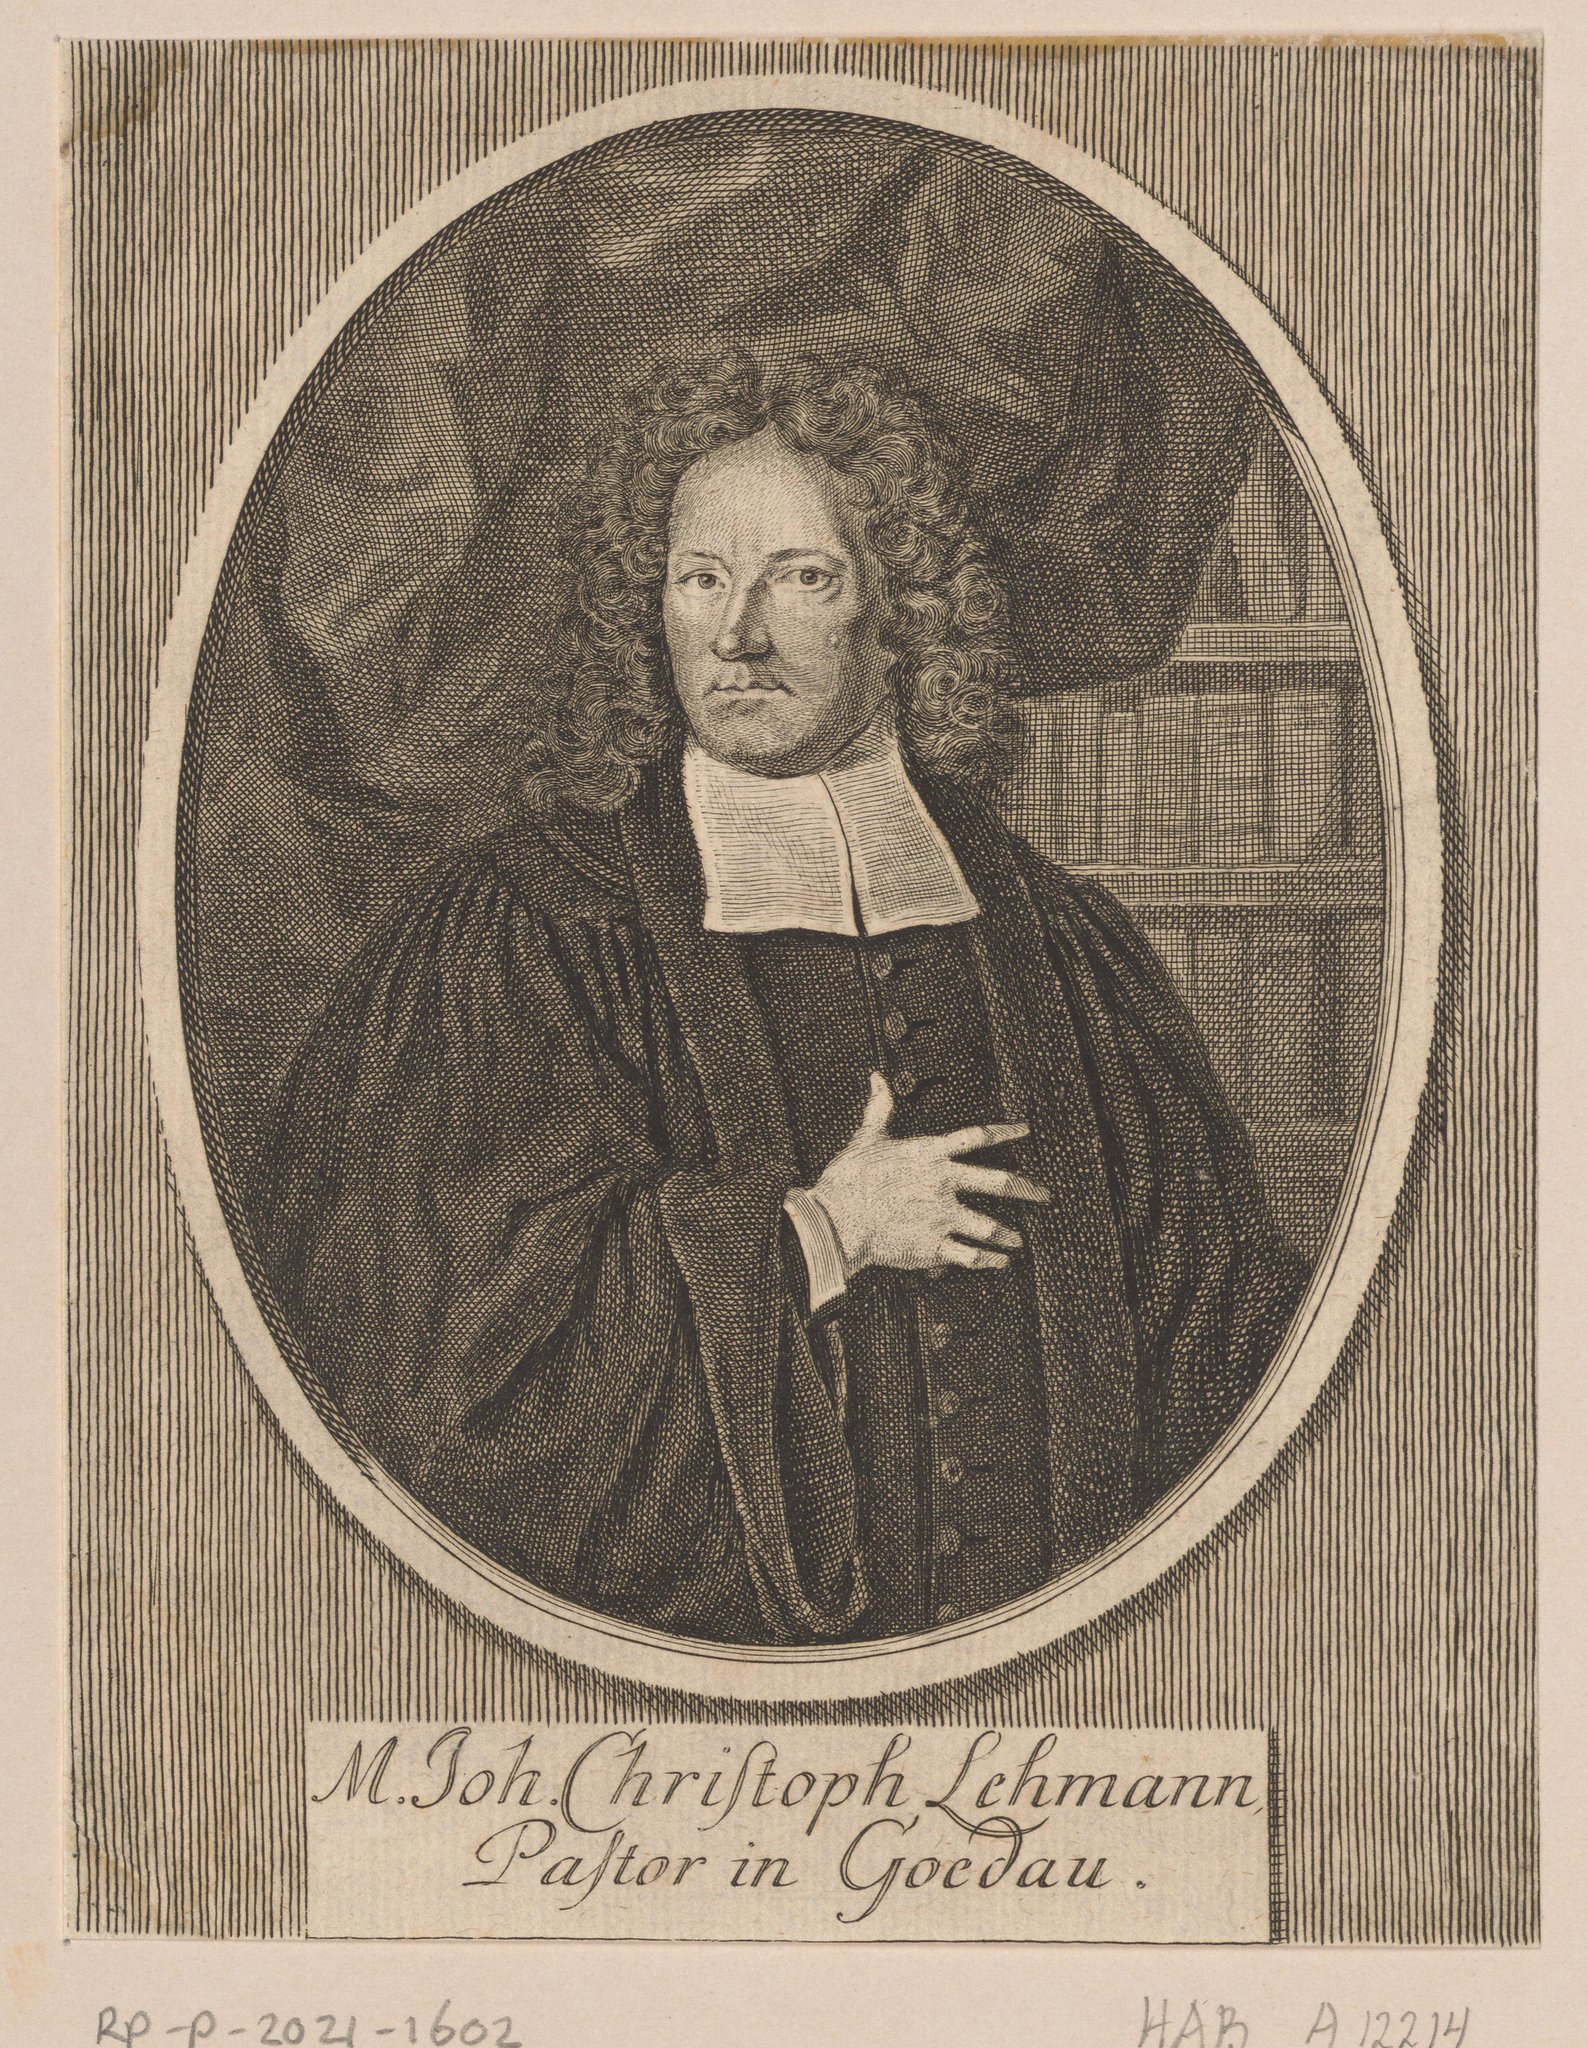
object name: print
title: Portret van Johann Christoph Lehmann (I) of Johann Christoph Lehmann (II)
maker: martin bernigeroth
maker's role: print maker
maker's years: 1670-1733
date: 1697-1750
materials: paper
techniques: engraving, etching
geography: germany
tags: bookshelves, ornament ~ medallion, historical persons